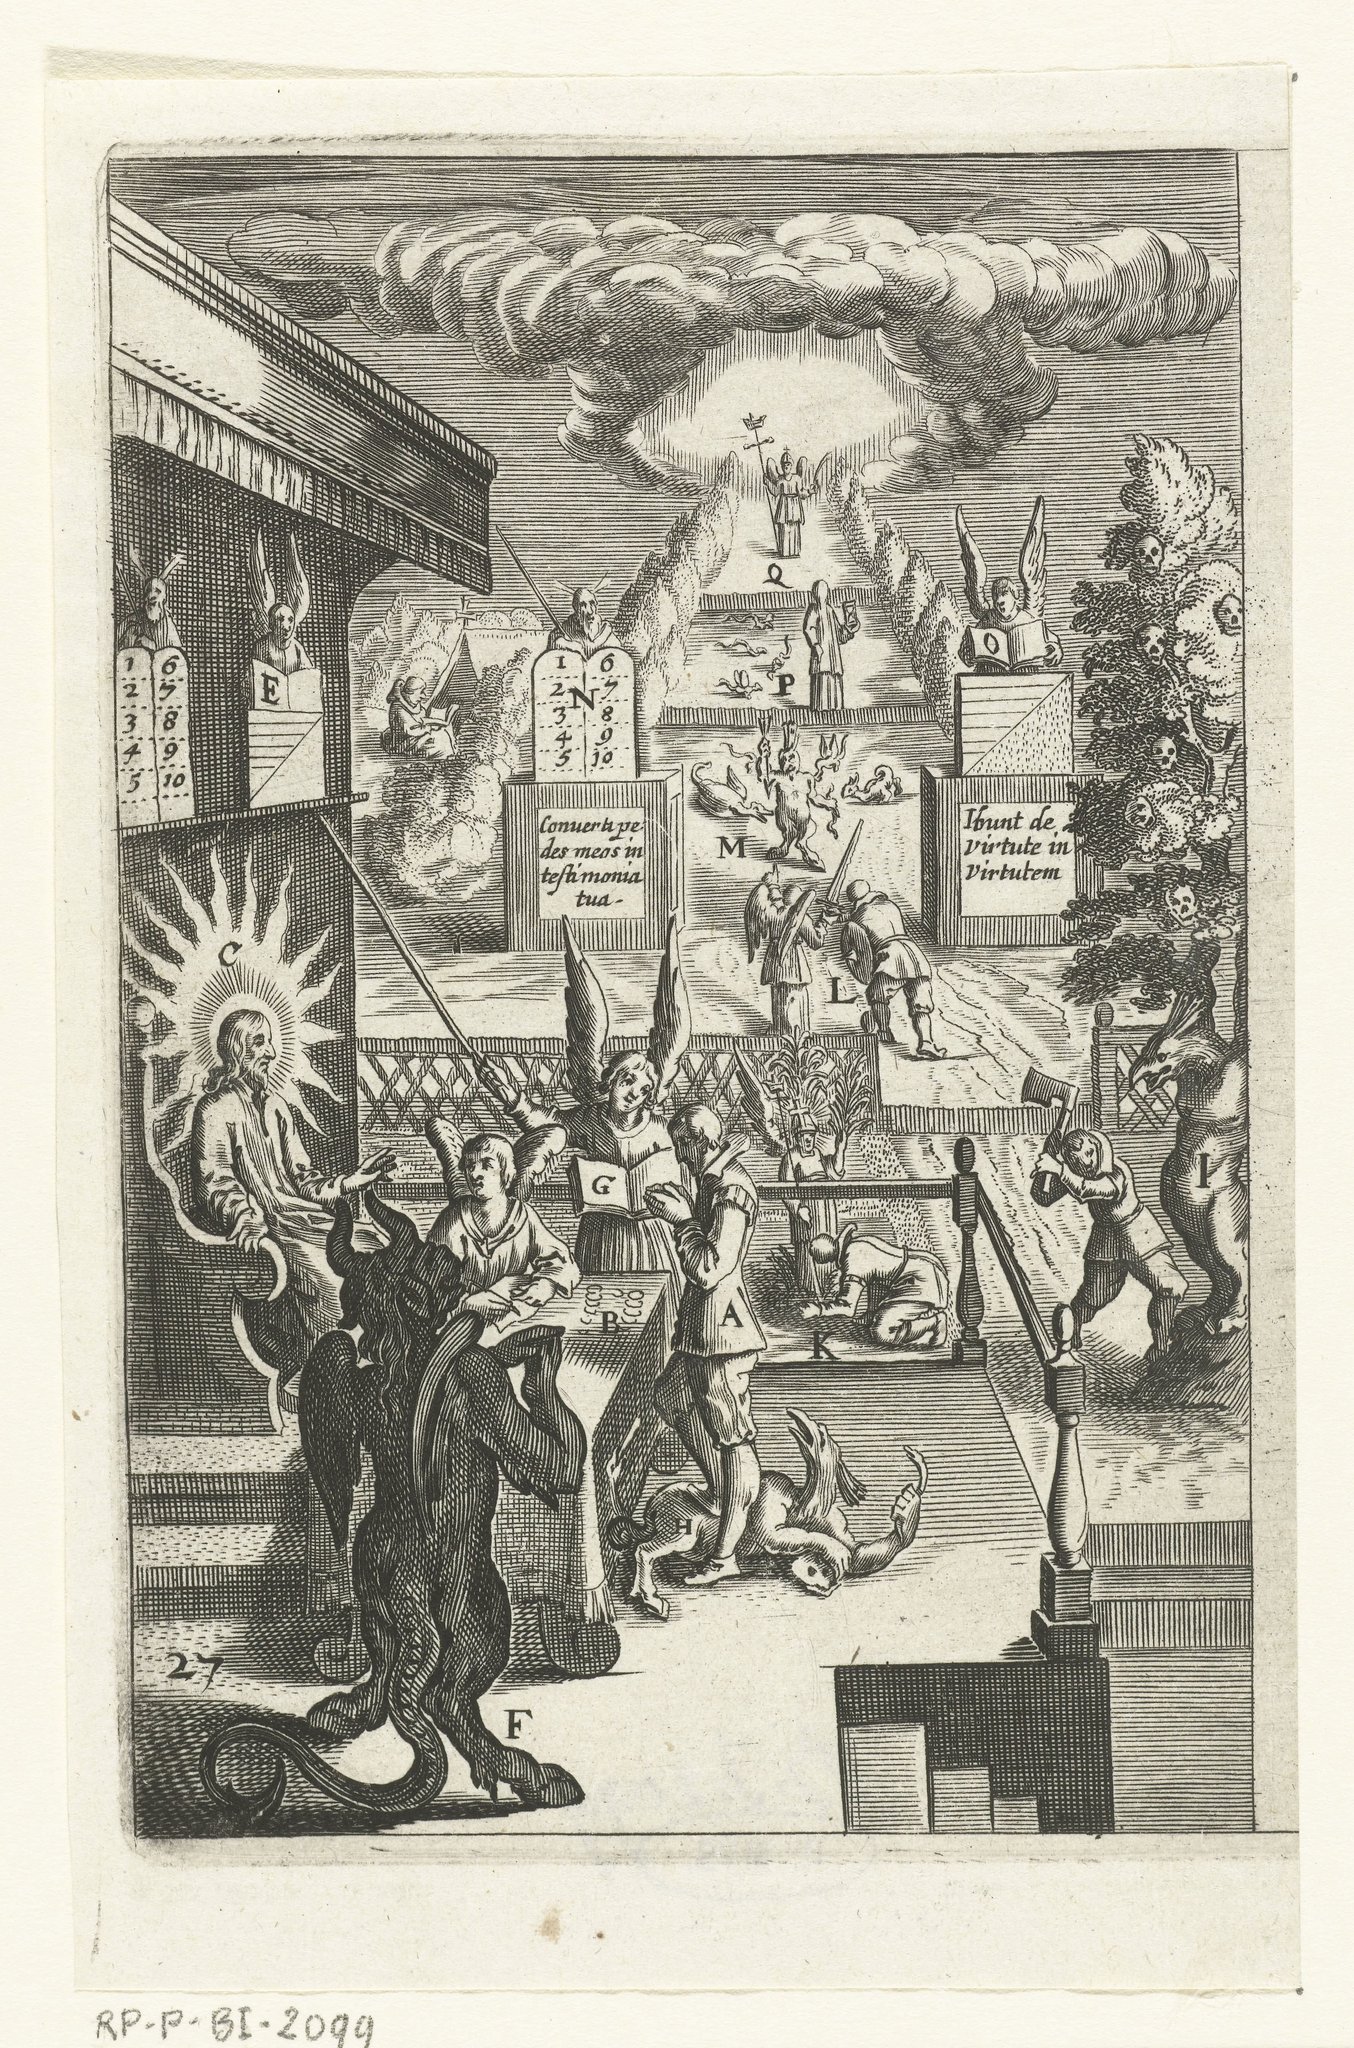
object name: book illustration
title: Embleem met man die door Christus als rechter beoordeeld wordt op zijn gebreken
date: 1620-1649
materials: paper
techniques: engraving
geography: antwerp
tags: devil(s) and demons, christ as (heavenly) judge, the life of man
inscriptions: collector's mark: Lugt 2228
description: Een man vraagt Christus als rechter de rekening van zijn zonden. De duivel doet een slecht woordje voor hem. Volgens het meditatievoorschrift moet hij bij zichzelf nagaan welke gebreken hij heeft en proberen de zonde uit zijn leven te bannen door volgens de tien geboden te leven.